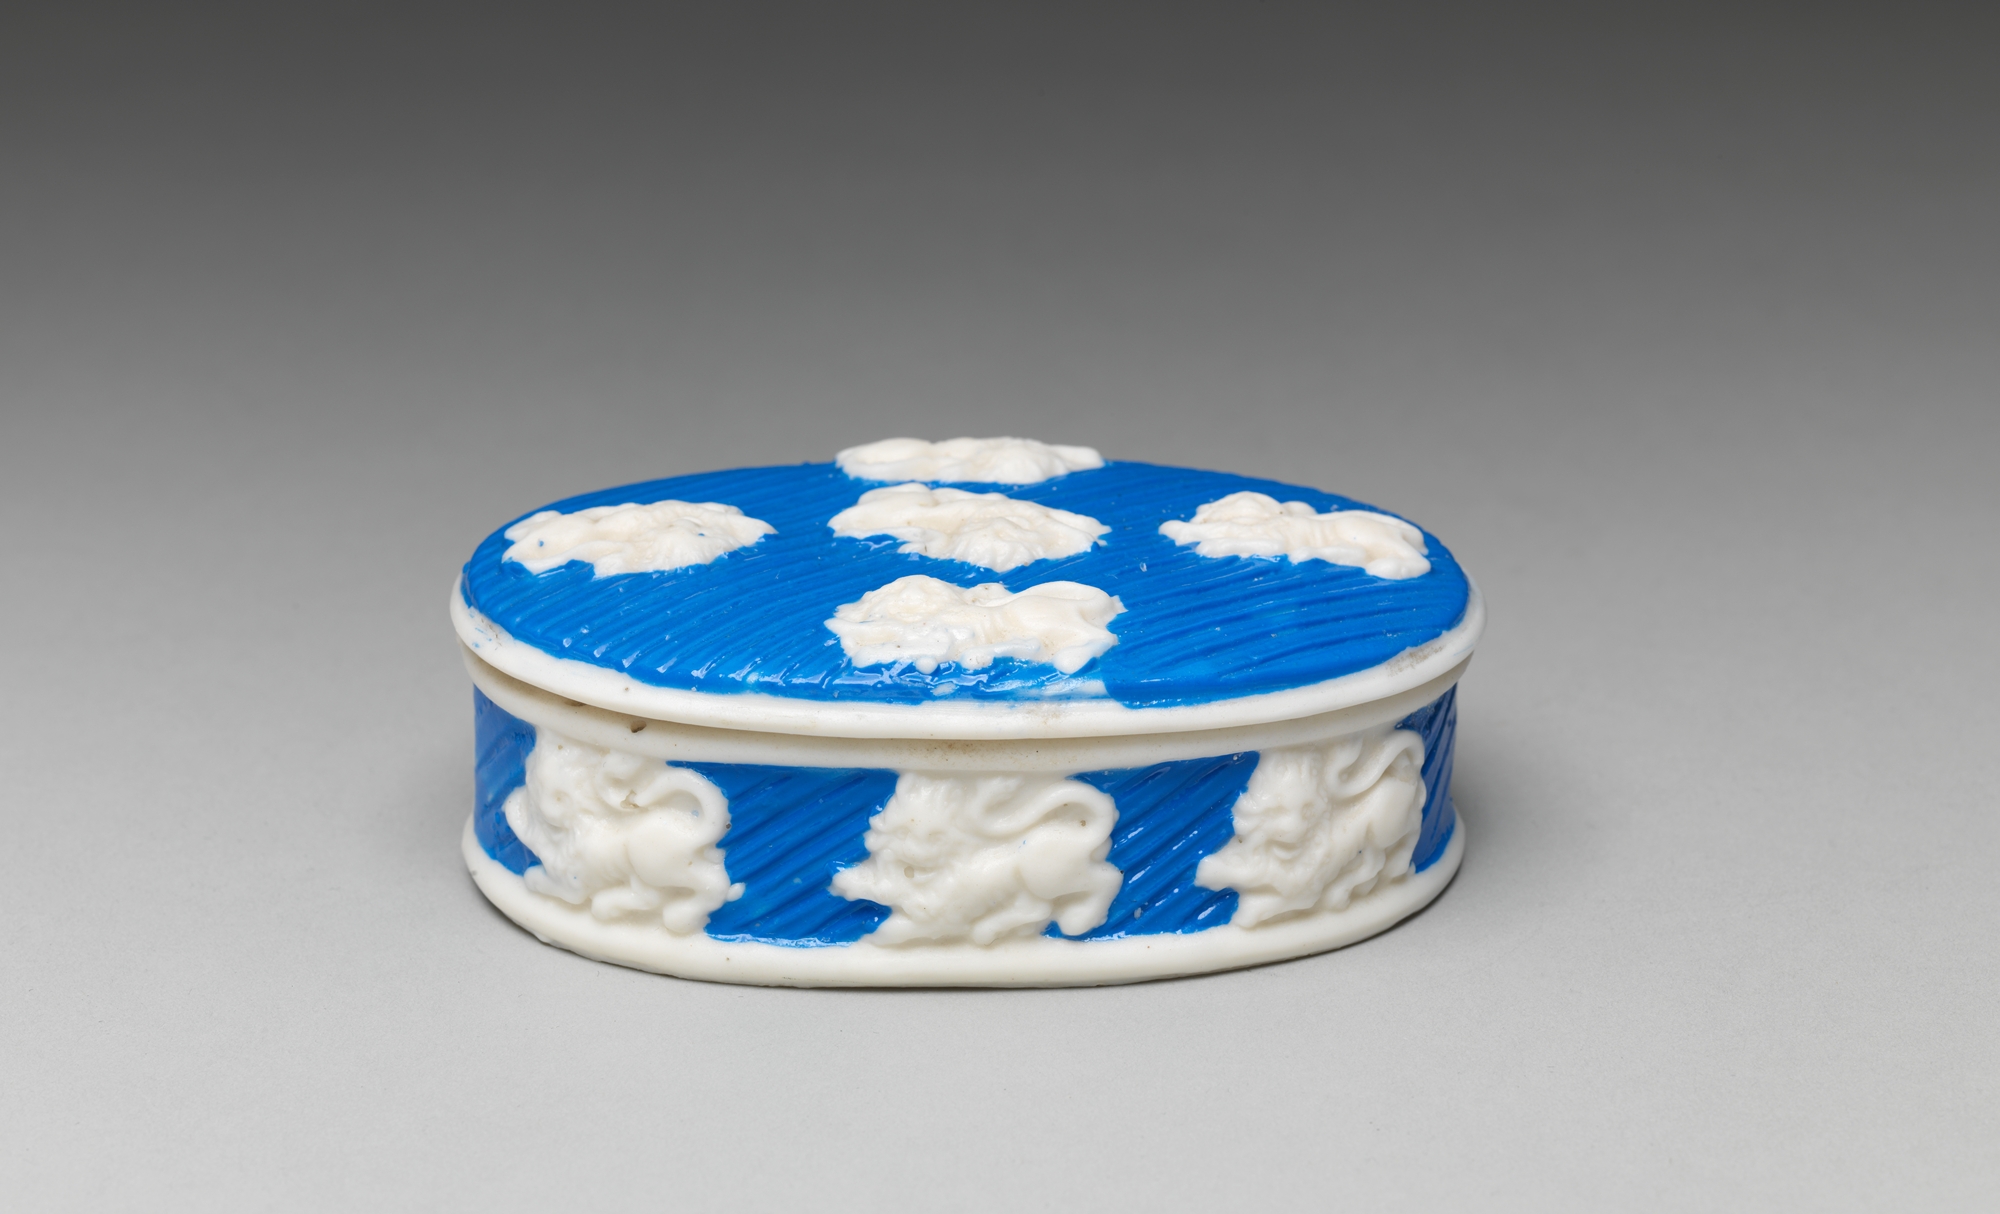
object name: trinket box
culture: american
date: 1830-1870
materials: porcelain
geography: united states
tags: animals